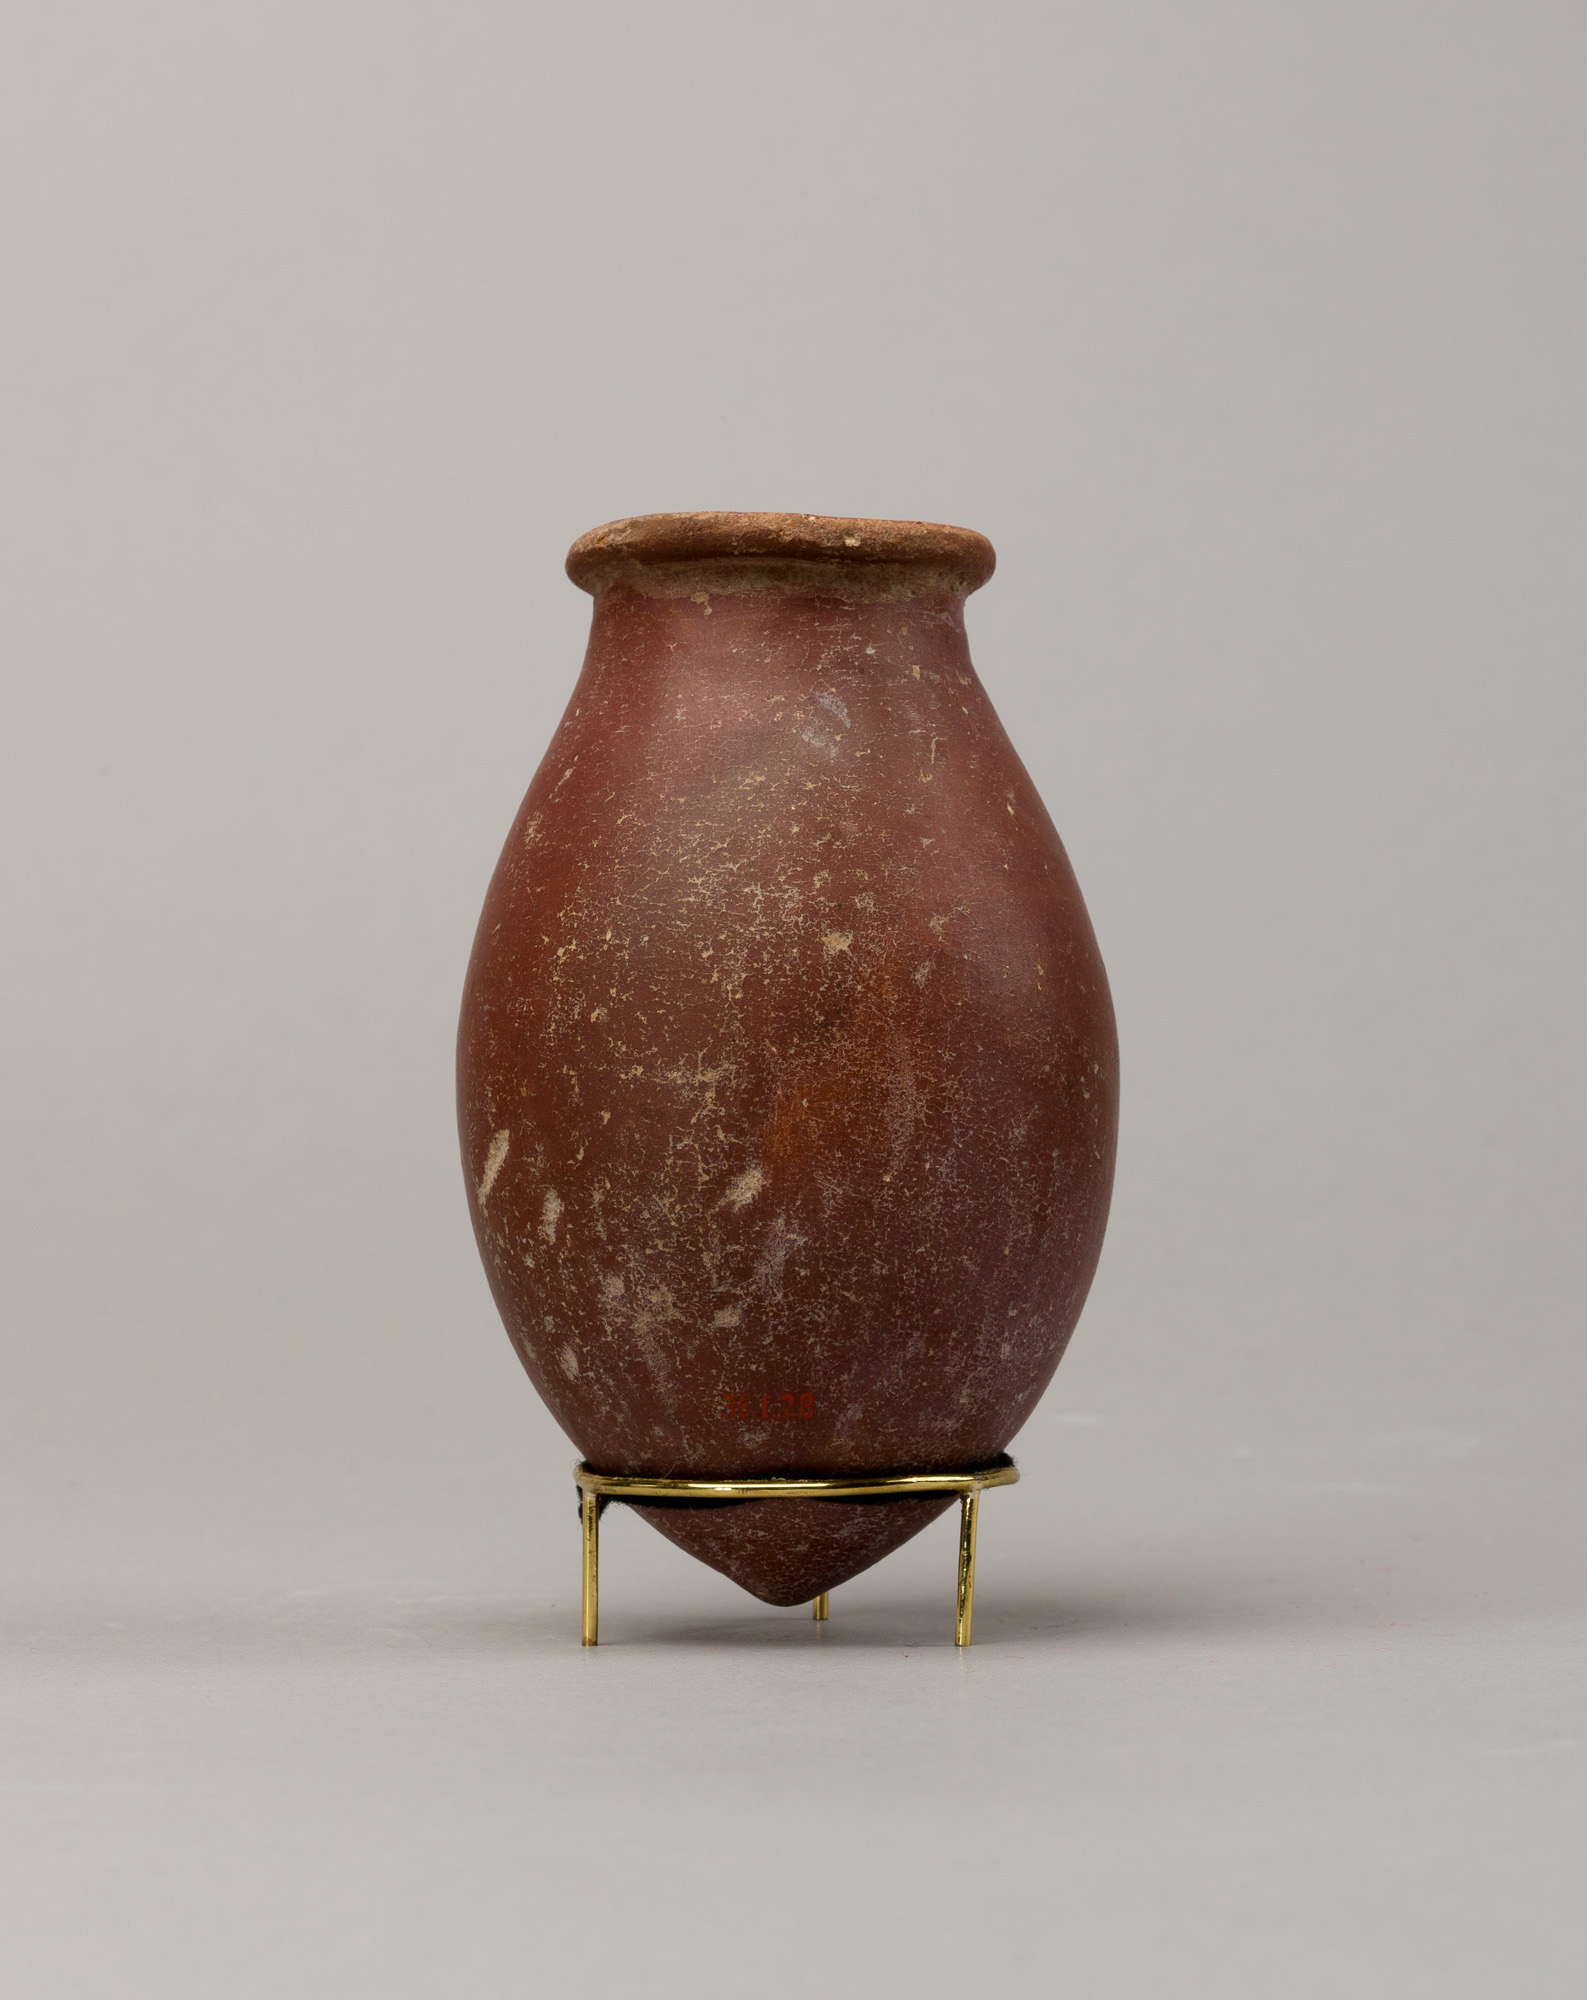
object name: jar, red polished ware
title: Red polished ware jar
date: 3850-2960 BCE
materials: pottery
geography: egypt